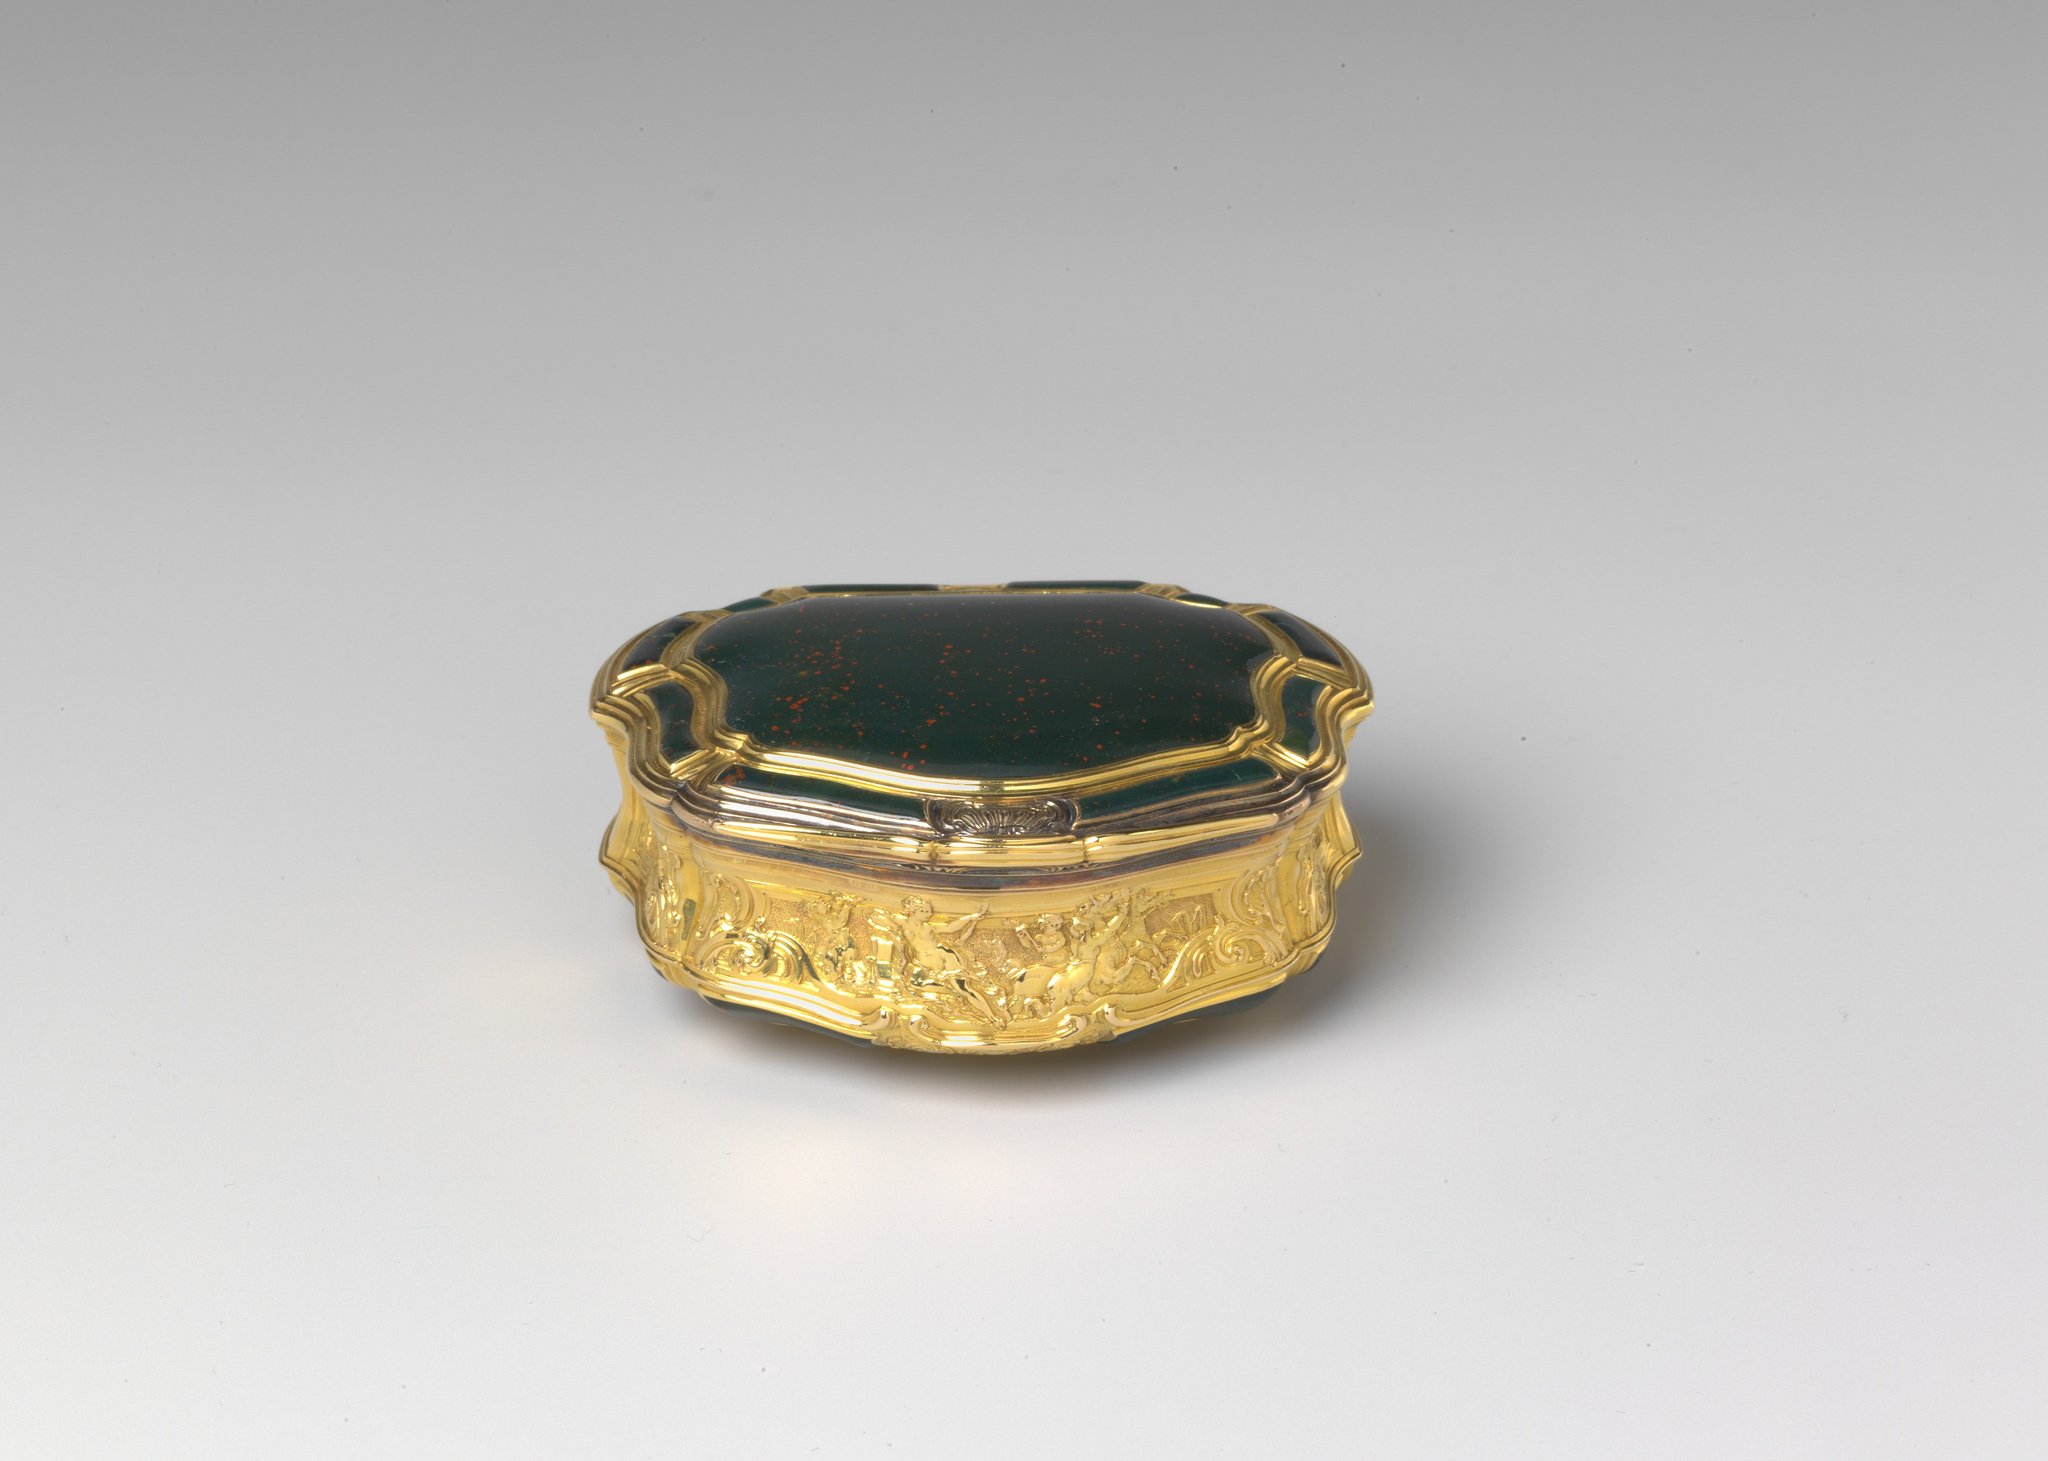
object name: snuffbox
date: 1740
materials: gold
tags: men,female nudes,carriages